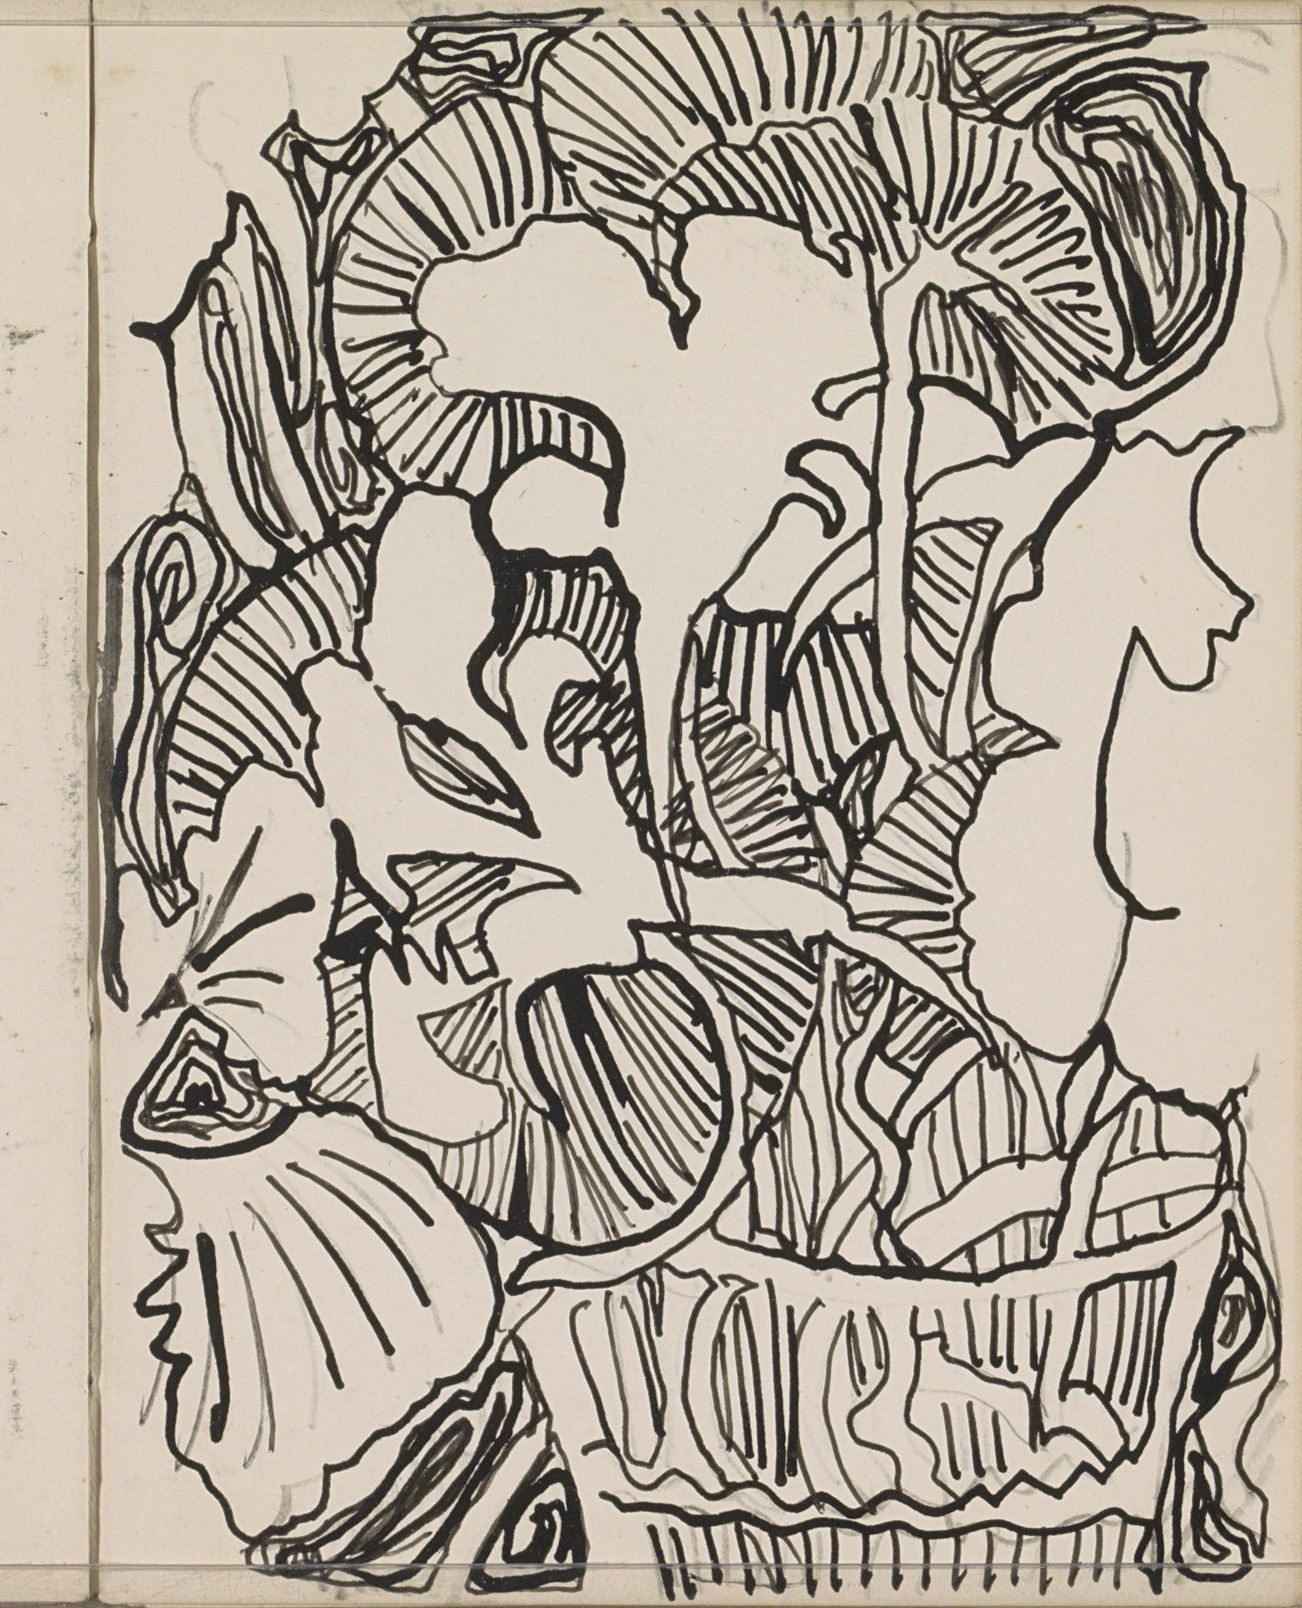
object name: sketchbook leaf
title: Plant in een pot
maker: reijer stolk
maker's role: draughtsman, print maker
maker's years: 1896-1945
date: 1916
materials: ink, paper, pencil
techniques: pen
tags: plants and herbs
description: Blad 59 recto uit een schetsboek met 72 bladen.